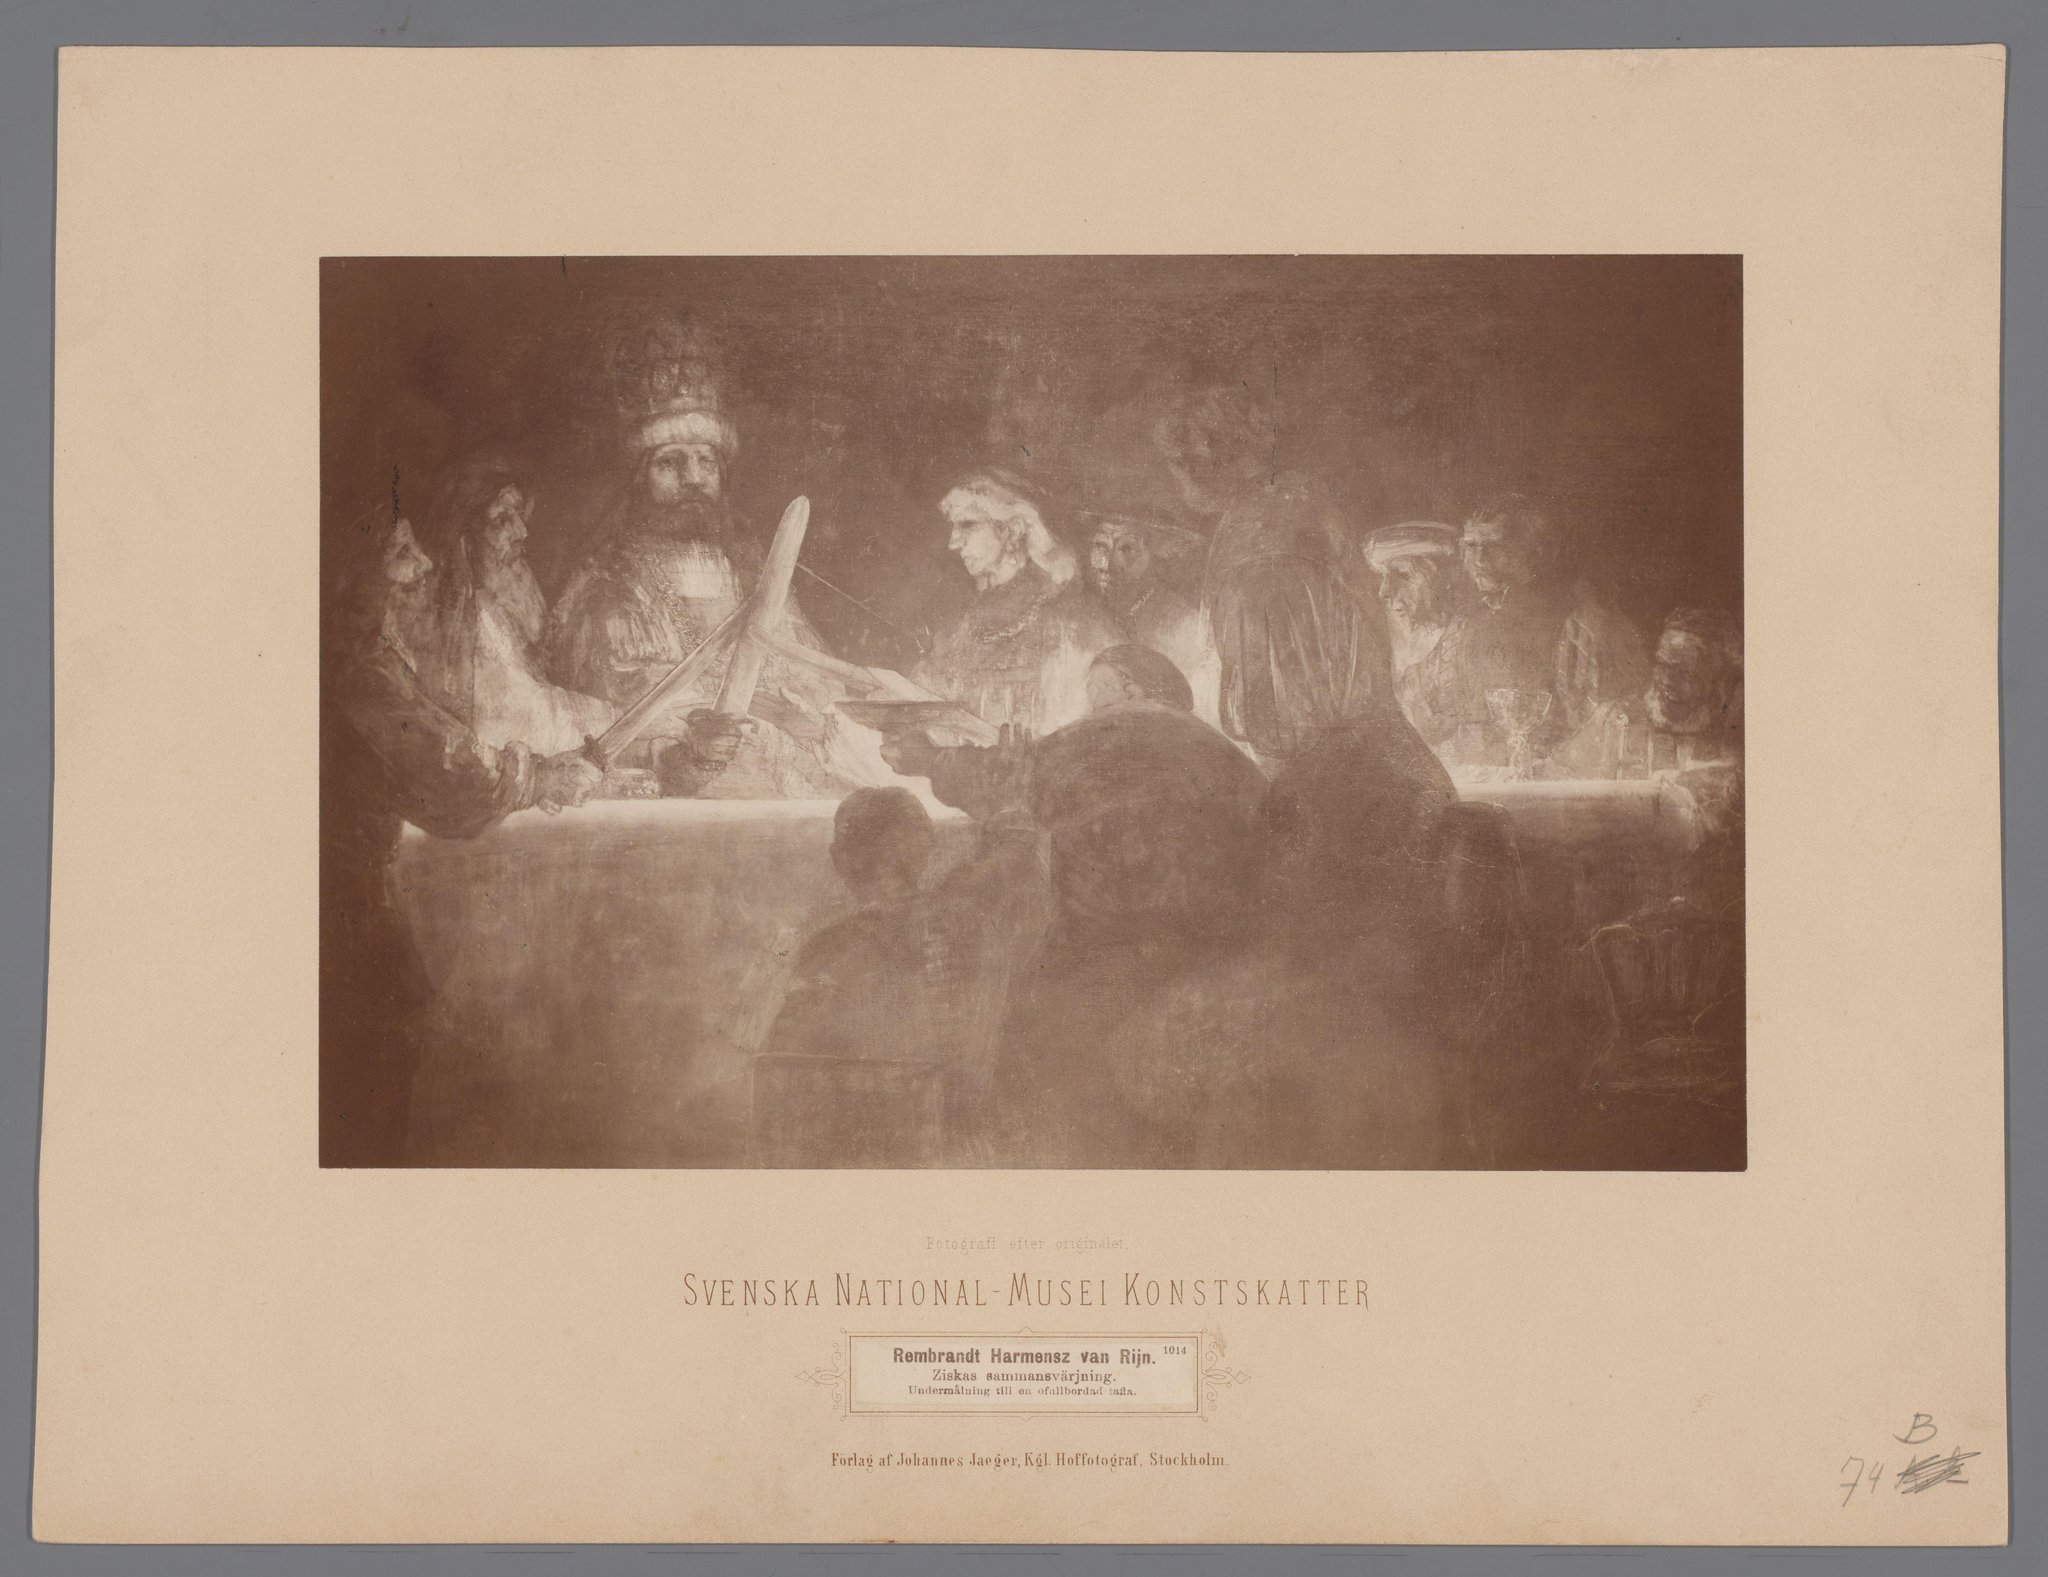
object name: reproduction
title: Rembrandt Harmensz van Rijn. Ziskas sammansvärjning, undermålning till en ofallbordad tafla.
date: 1865-1890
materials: cardboard, paper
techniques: albumen print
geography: stockholm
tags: leiden, amsterdam, painter, print maker, rembrandt van rijn, picture, painting